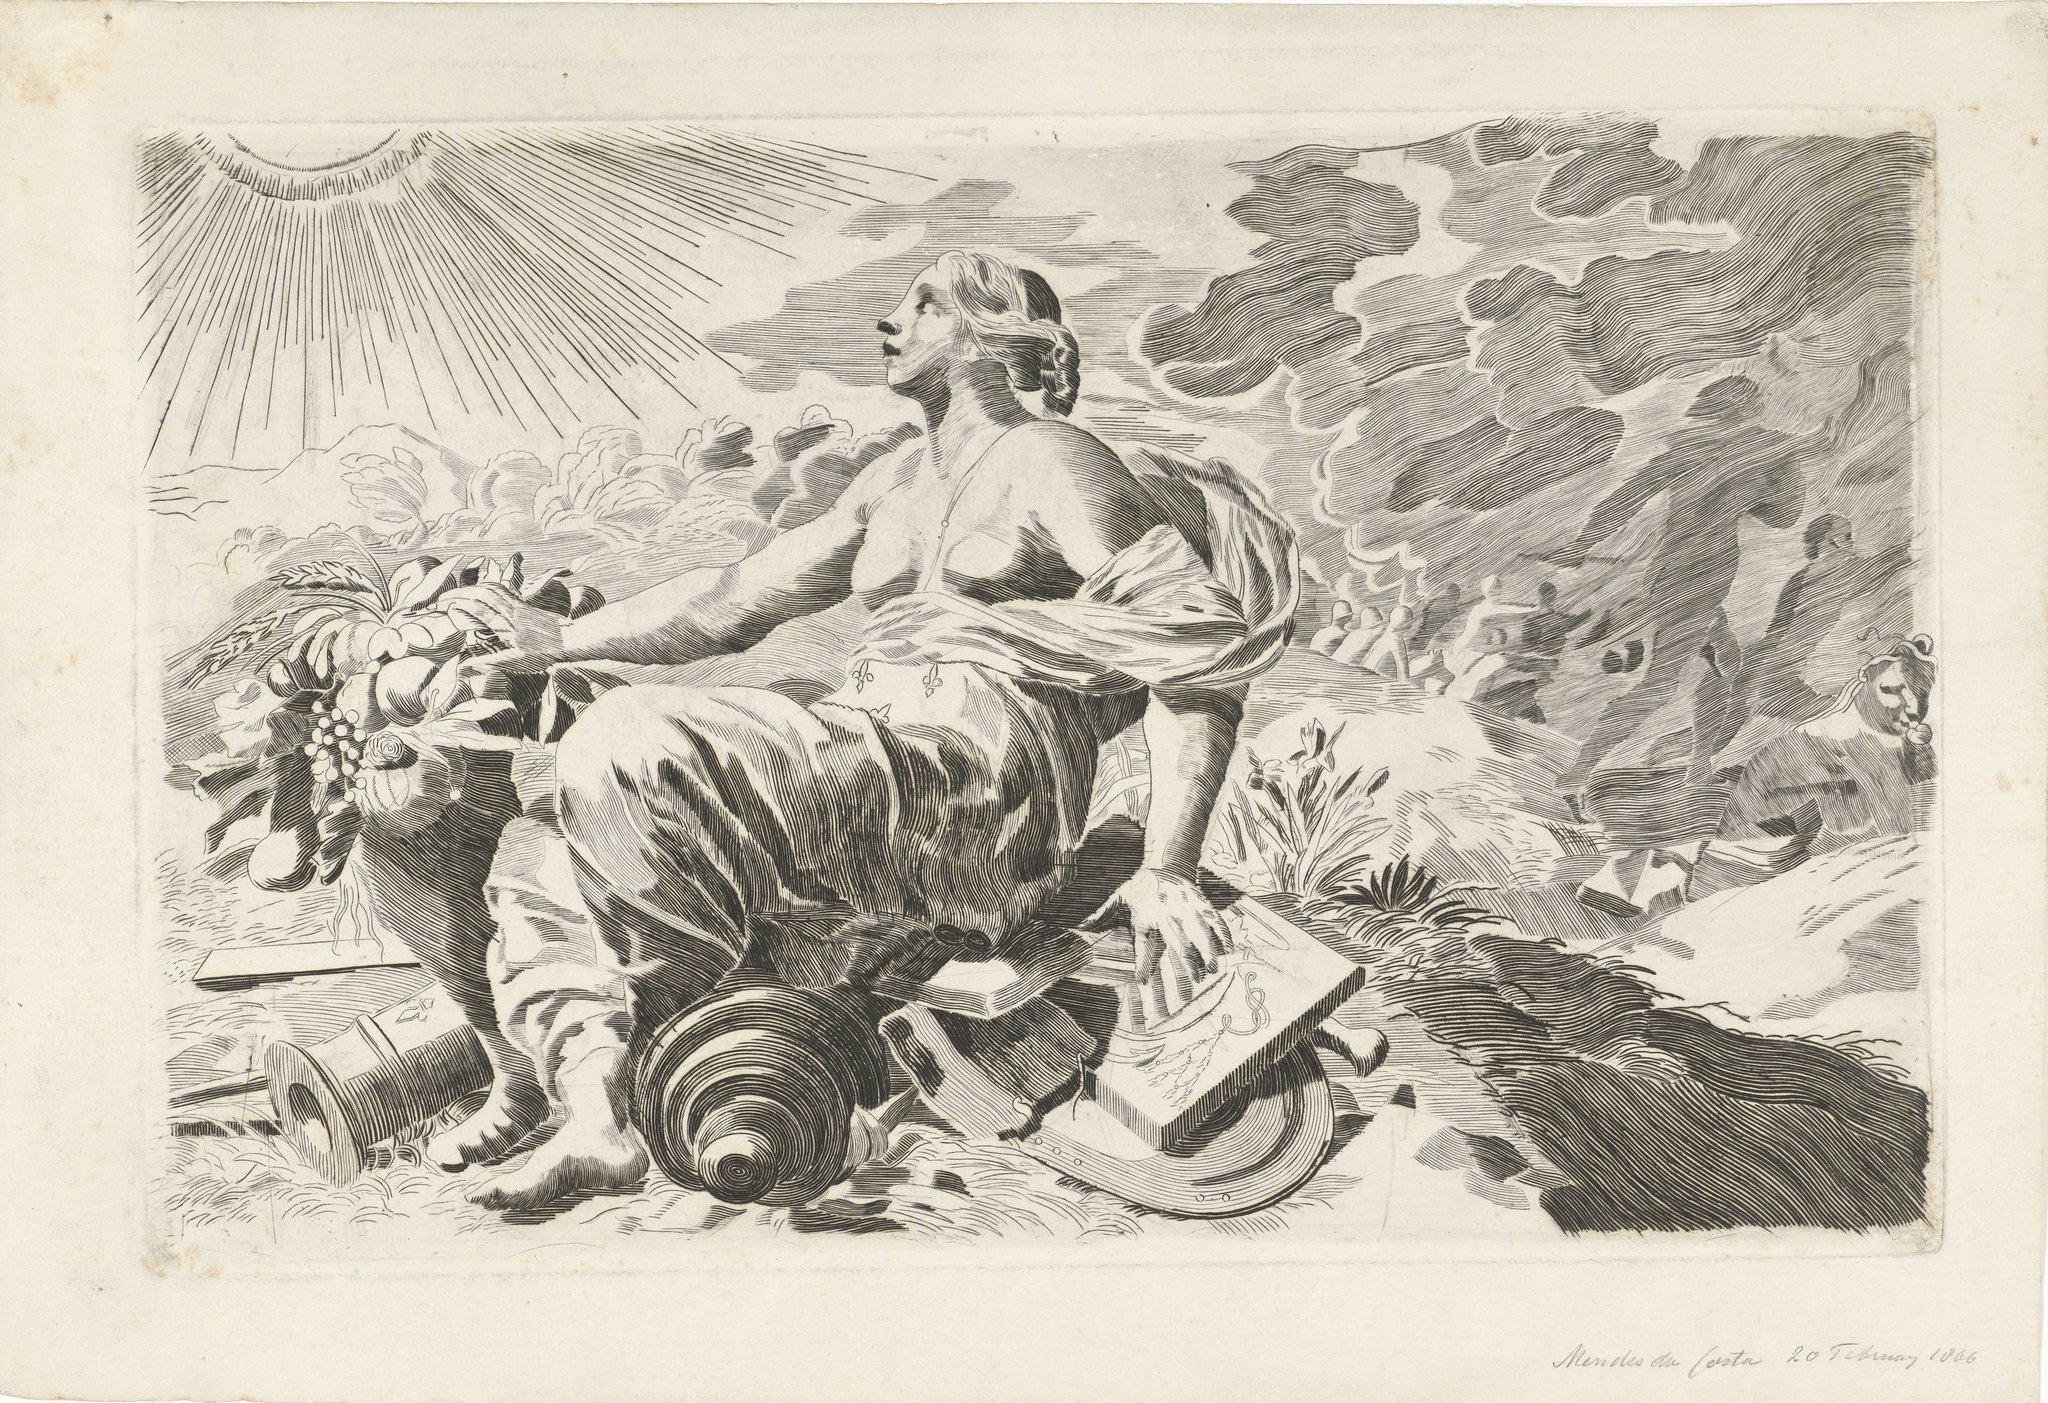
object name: print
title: Allegorie op de voorspoed van een kardinaal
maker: samuel henri mendes da costa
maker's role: draughtsman, print maker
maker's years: 1845-1923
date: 1866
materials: paper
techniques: etching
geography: amsterdam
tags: welfare, prosperity; 'felicità publica', 'prosperità della vita', 'salute' (ripa) (+ partially clothed), insignia of cardinal, e.g. hat, mantle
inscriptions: collector's mark: Lugt 2228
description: Een vrouw, de personificatie van de voorspoed, is gehuld in een doek met Franse lelies, zit op een kanon en kijkt naar de zon. Haar hand leunt op een steen met een onbekend kardinaalswapen. Op de achtergrond de brokstukken van een gebeeldhouwde leeuw en vluchtende mensen tussen dikke rookwolken.